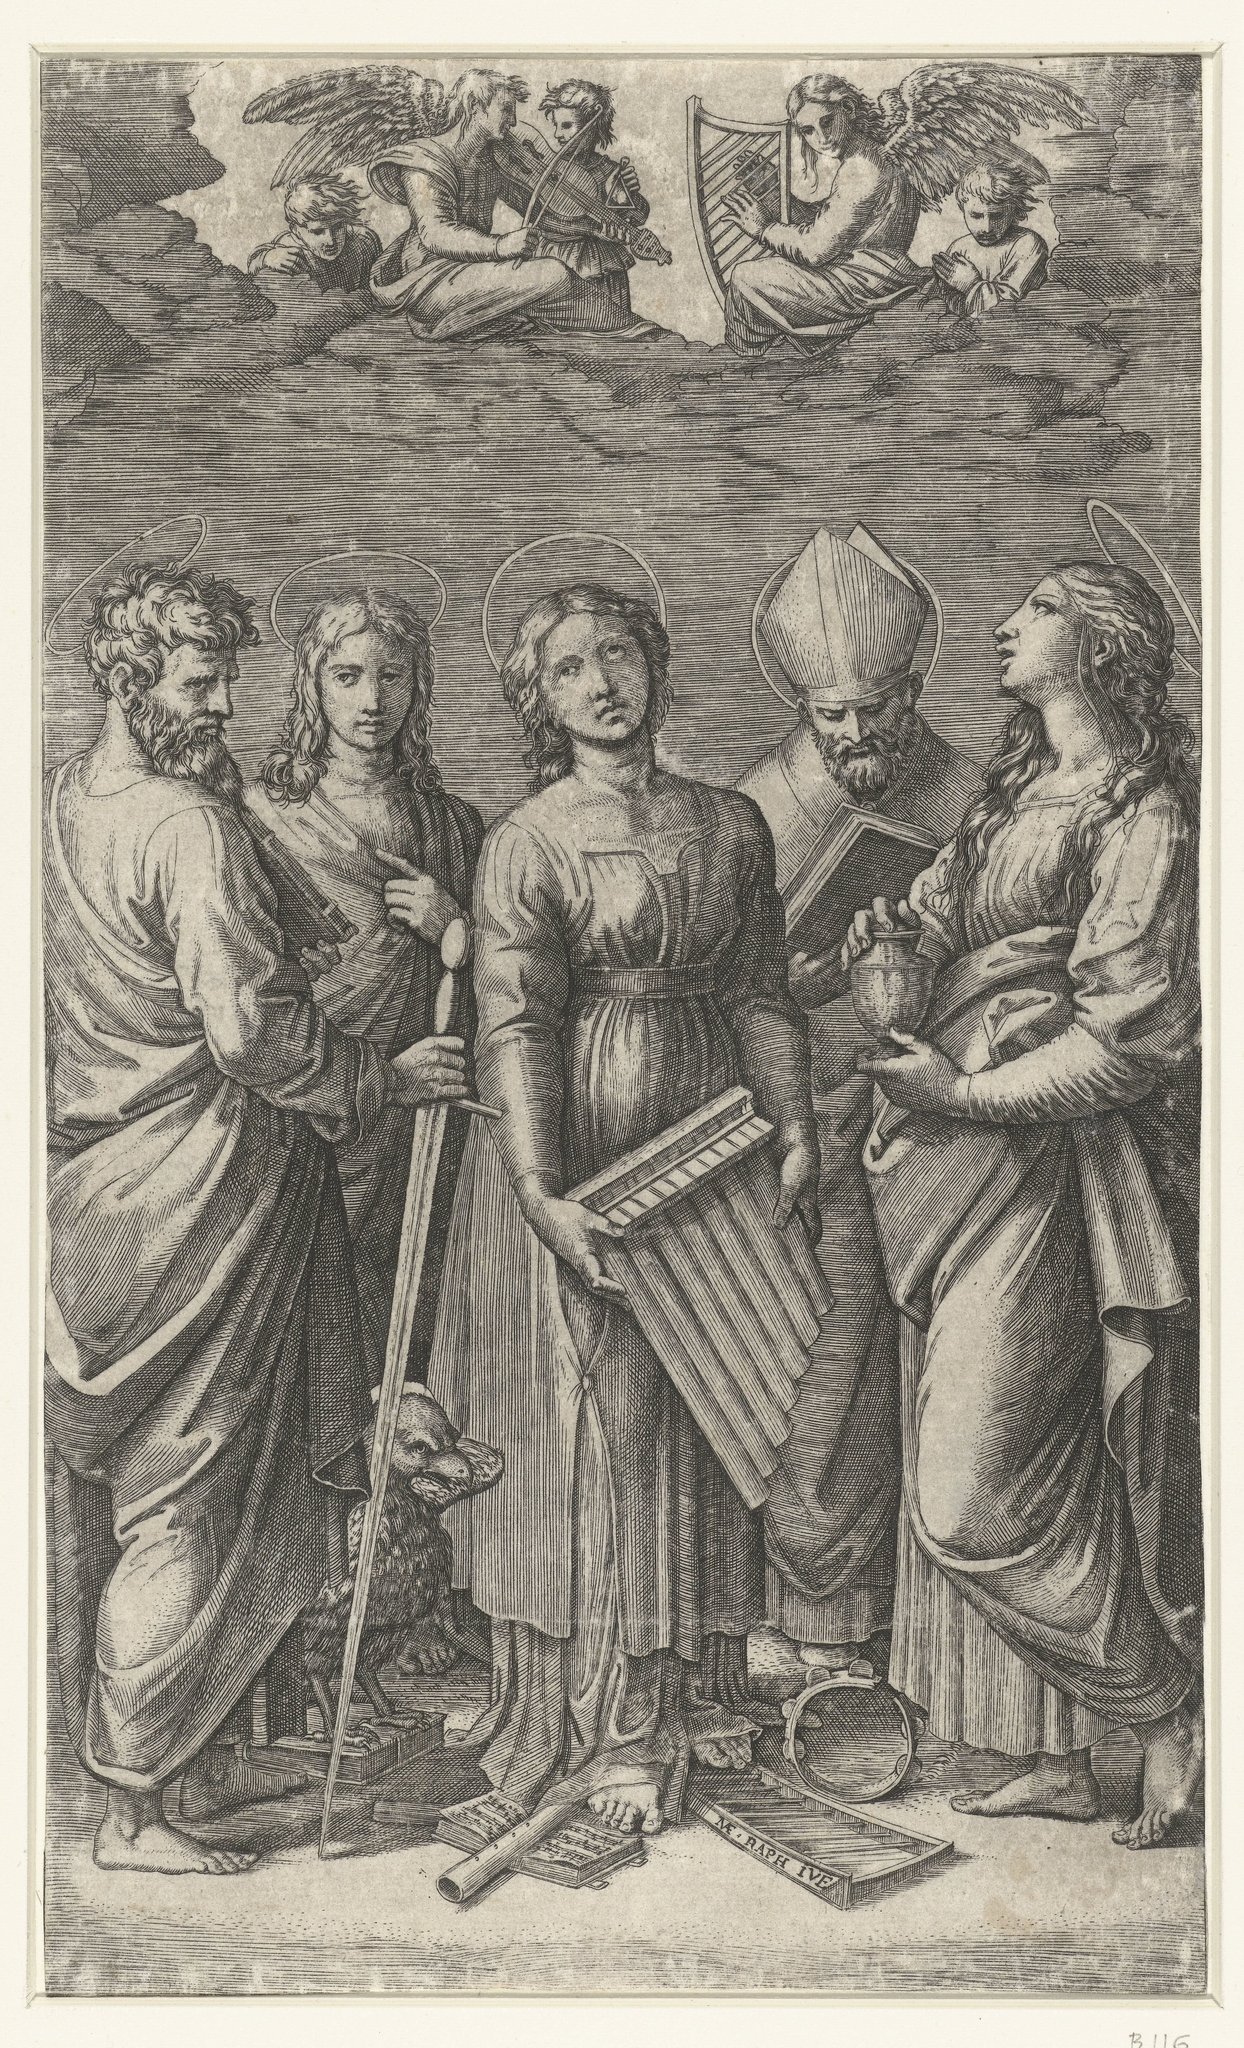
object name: print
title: Heilige Cecilia met muziekinstrumenten omringd door vier heiligen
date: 1515-1516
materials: paper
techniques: engraving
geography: italy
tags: the virgin martyr cecilia of rome; possible attributes: falcon, musical instruments, organ, wreath of roses and lilies, the apostle john the evangelist; possible attributes: book, cauldron, chalice with snake, eagle, palm, scroll, organ, male saints (with name), the penitent harlot mary magdalene; possible attributes: book (or scroll), crown, crown of thorns, crucifix, jar of ointment, mirror, musical instrument, palm-branch, rosary, scourge, the apostle paul of tarsus; possible attributes: book, scroll, sword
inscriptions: collector's mark: Lugt 240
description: Prent naar ontwerp van Raphael. In de collectie van het Musée du Petit Palais, Parijs, wordt een tekening bewaard met dezelfde voorstelling welke is toegeschreven aan een leerling van Raphael, Giovanni Francesco Penni. Waarschijnlijk hebben de vervaardigers van zowel de tekening als de gravure dezelfde inspiratiebron gebruikt, een ontwerptekening voor het schilderij van Raphael in de S. Giovanni in Monte, Bologna (Shoemaker 1981, p. 112).